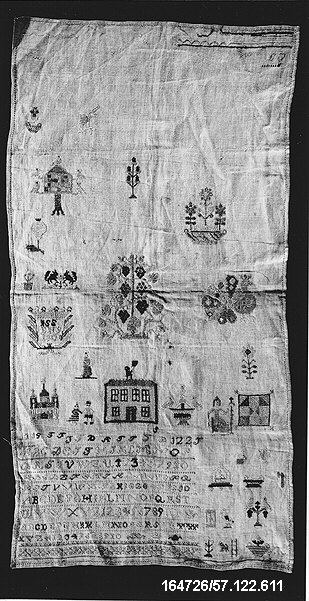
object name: sampler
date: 1801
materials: linen, silk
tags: birds,houses,flowers